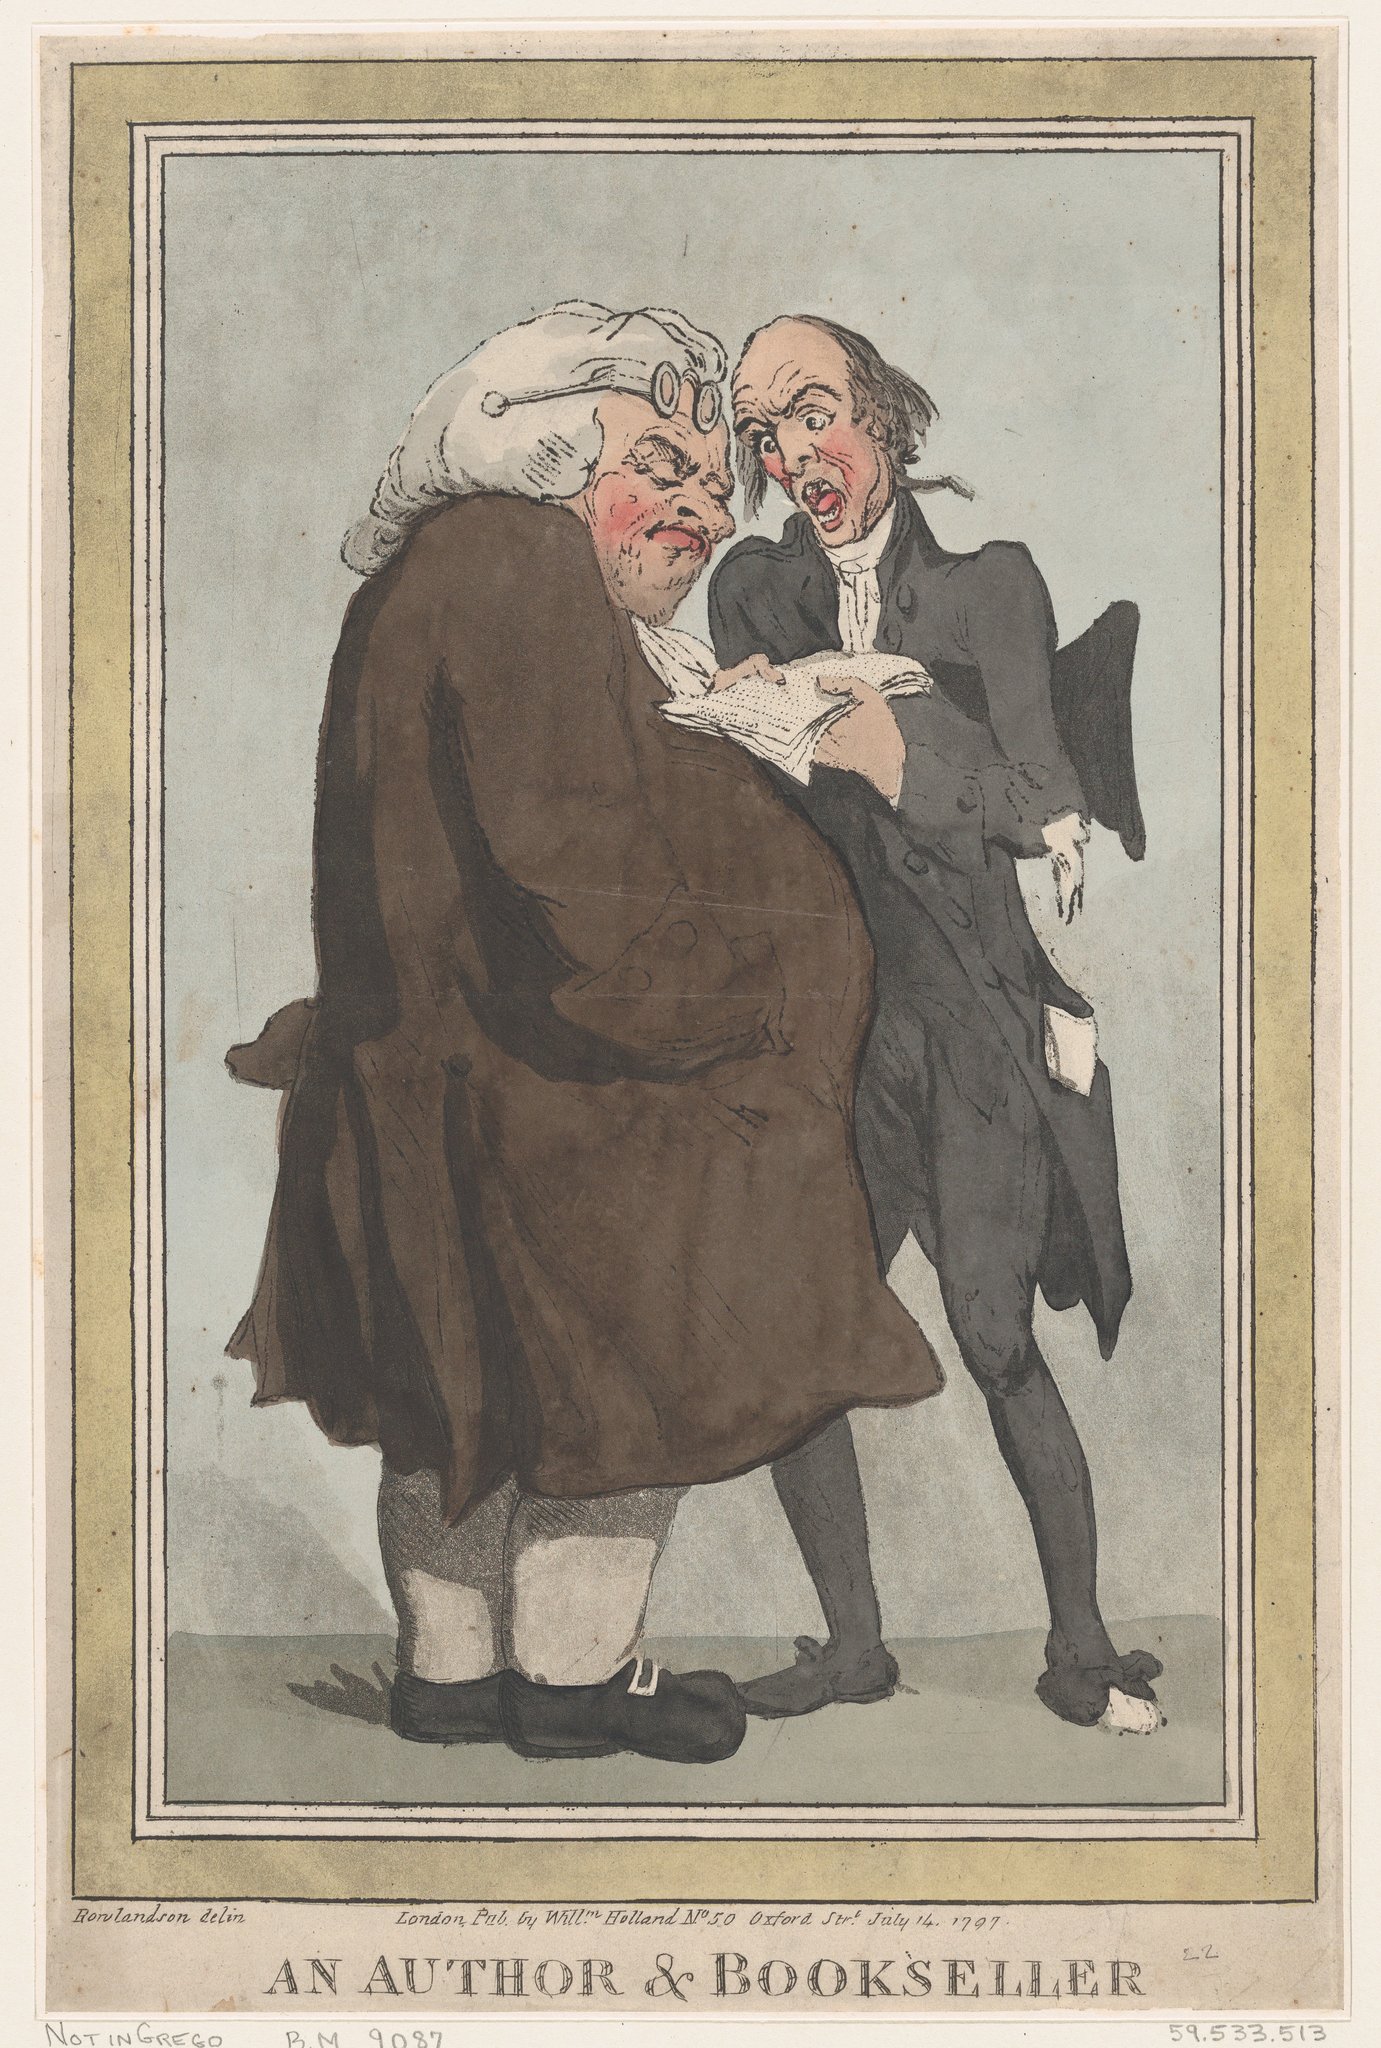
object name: print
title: An Author & Bookseller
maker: thomas rowlandson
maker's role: artist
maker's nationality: british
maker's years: 1757-1827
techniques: etching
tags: men